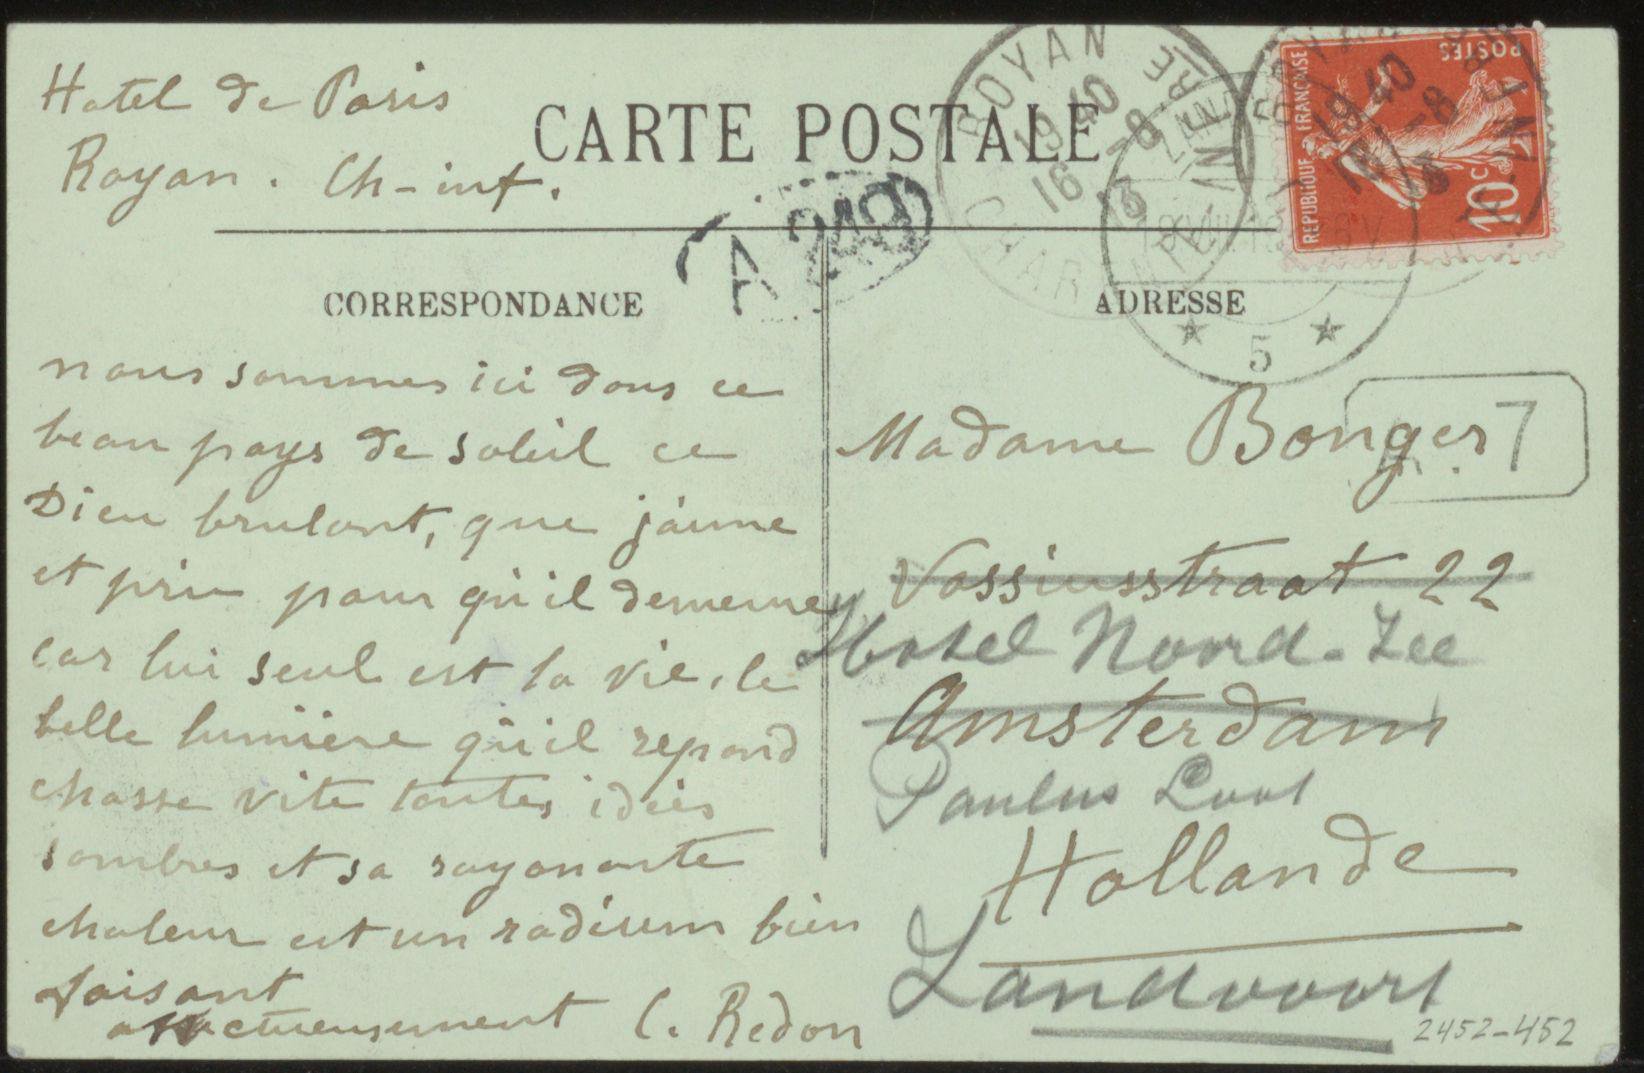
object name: ansichtkaart, prentbriefkaart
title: Prentbriefkaart aan Anne Marie Louise van der Linden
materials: cardboard, ink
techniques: photograph, pen, writing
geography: royan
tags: anne marie louise van der linden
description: Prentbriefkaart behoort tot een album samengesteld door weduwe Françoise W.M. Barones van der Borch van Verwolde met afschriften van brieven met betrekking tot (de familie van) Odilon Redon. De prentbriefkaart werd bewaard op pagina 102.